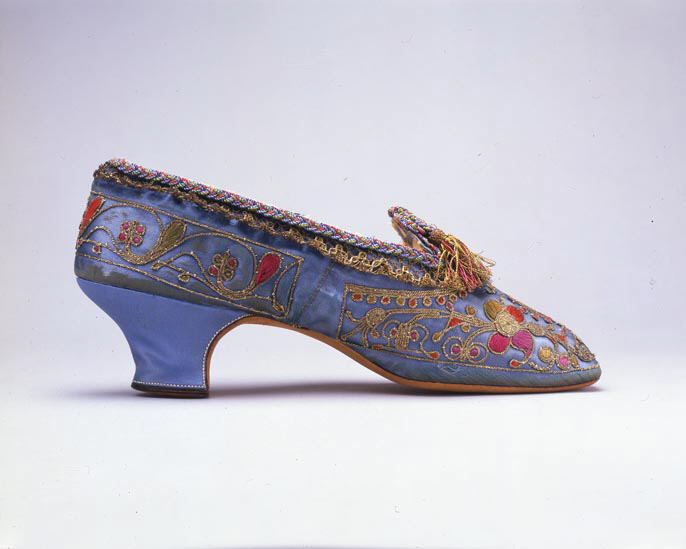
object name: pump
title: Pumps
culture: french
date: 1873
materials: metal thread, silk